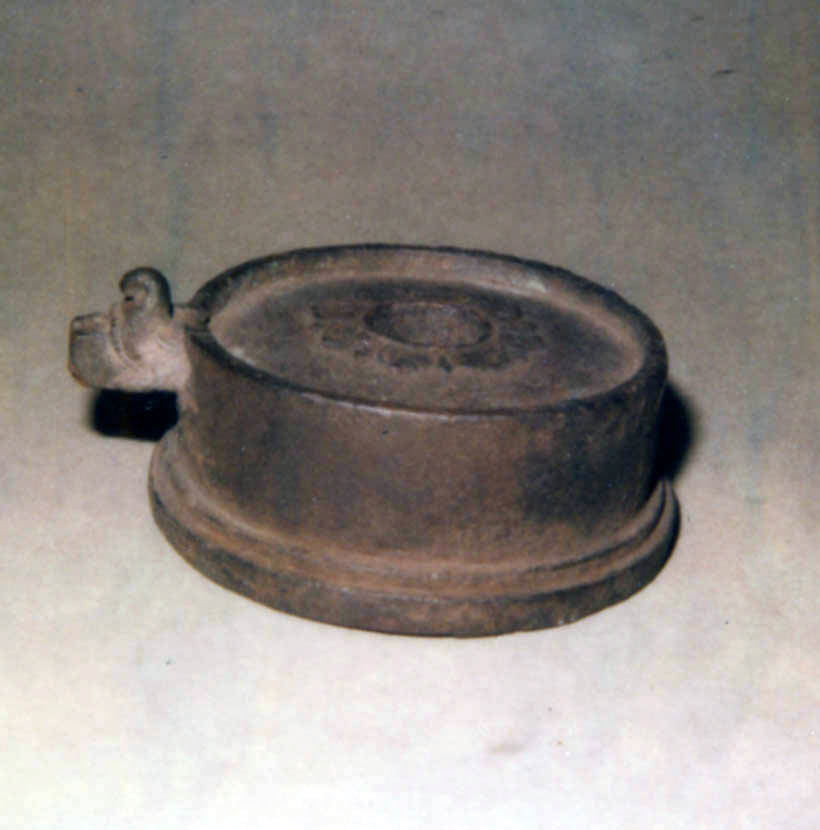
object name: linga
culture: nepali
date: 1001-1200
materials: bronze